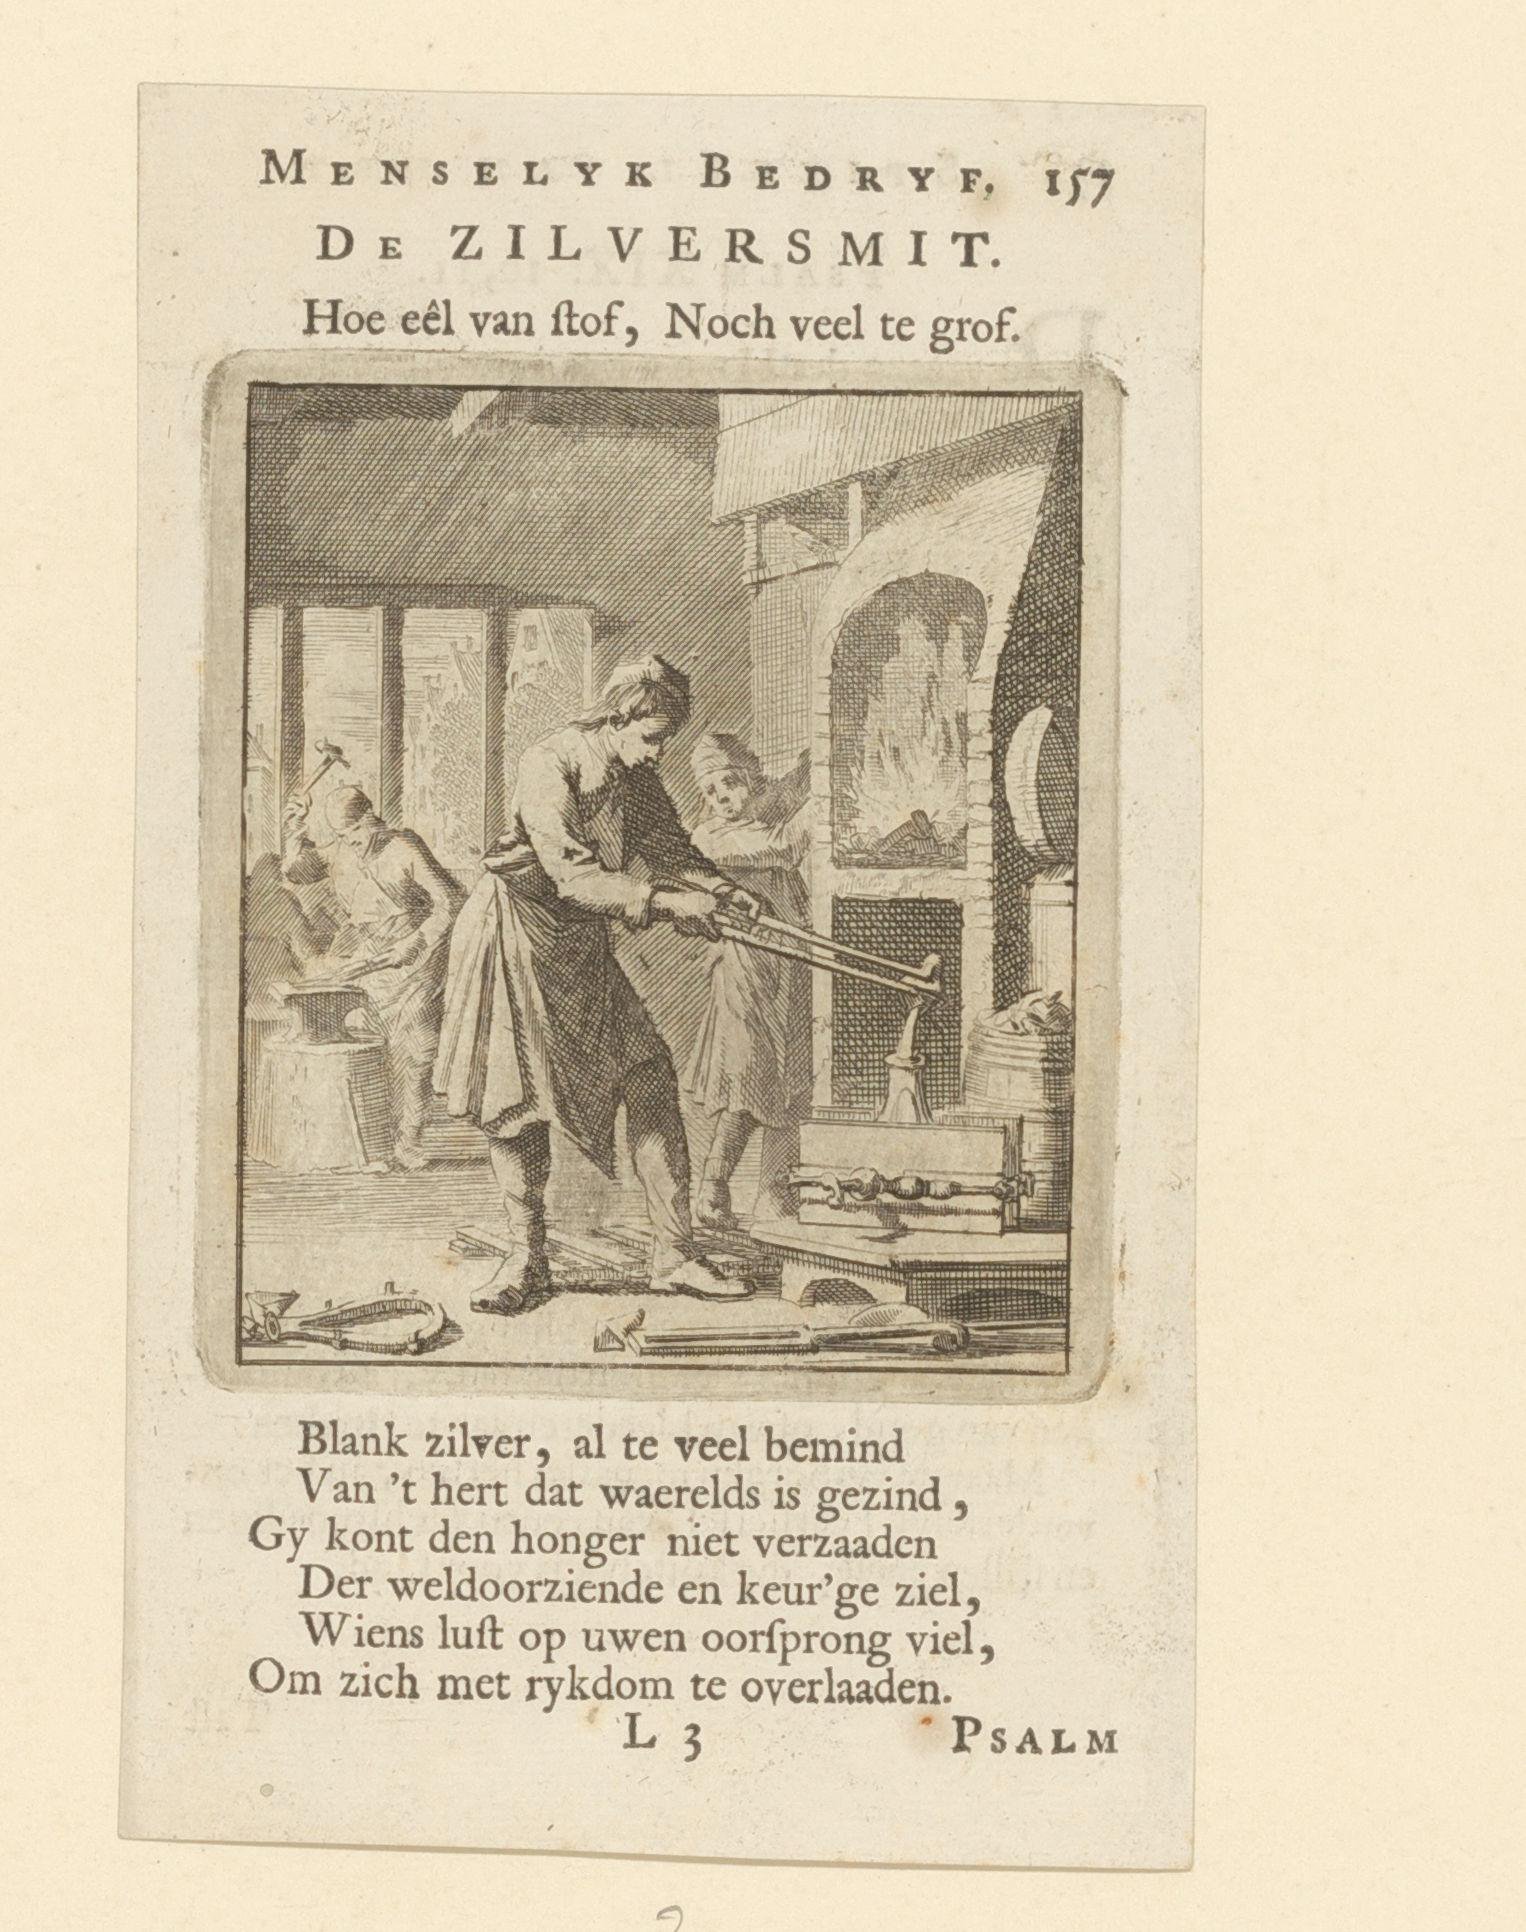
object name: print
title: De Zilversmit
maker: cornelis van der sys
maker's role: publisher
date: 1718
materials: paper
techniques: etching, letterpress printing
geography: amsterdam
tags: handicrafts, craftsman at work, jeweller, goldsmith, silversmith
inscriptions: stamp, collector's mark: Lugt 1641, stamp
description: Prent oorspronkelijk verschenen in de 100-delige serie beroepsprenten van Jan en Caspar Luyken, getiteld: Het menselyk bedryf. S.l.s.n., 1694 (eerste druk). Daarna is de titel en het vers afgesneden. De prenten in diverse publicaties verschenen en gekopieerd. Huidige staat uit: Luyken, Jan en Caspar. Spiegel van het menselyk bedryf (...). Amsterdam: Cornelis van der Sys, 1718, p. 157. Prent waarschijnlijk ook gebruikt in eerdere (1704) en latere (1730, 1749, 1767) publicaties.